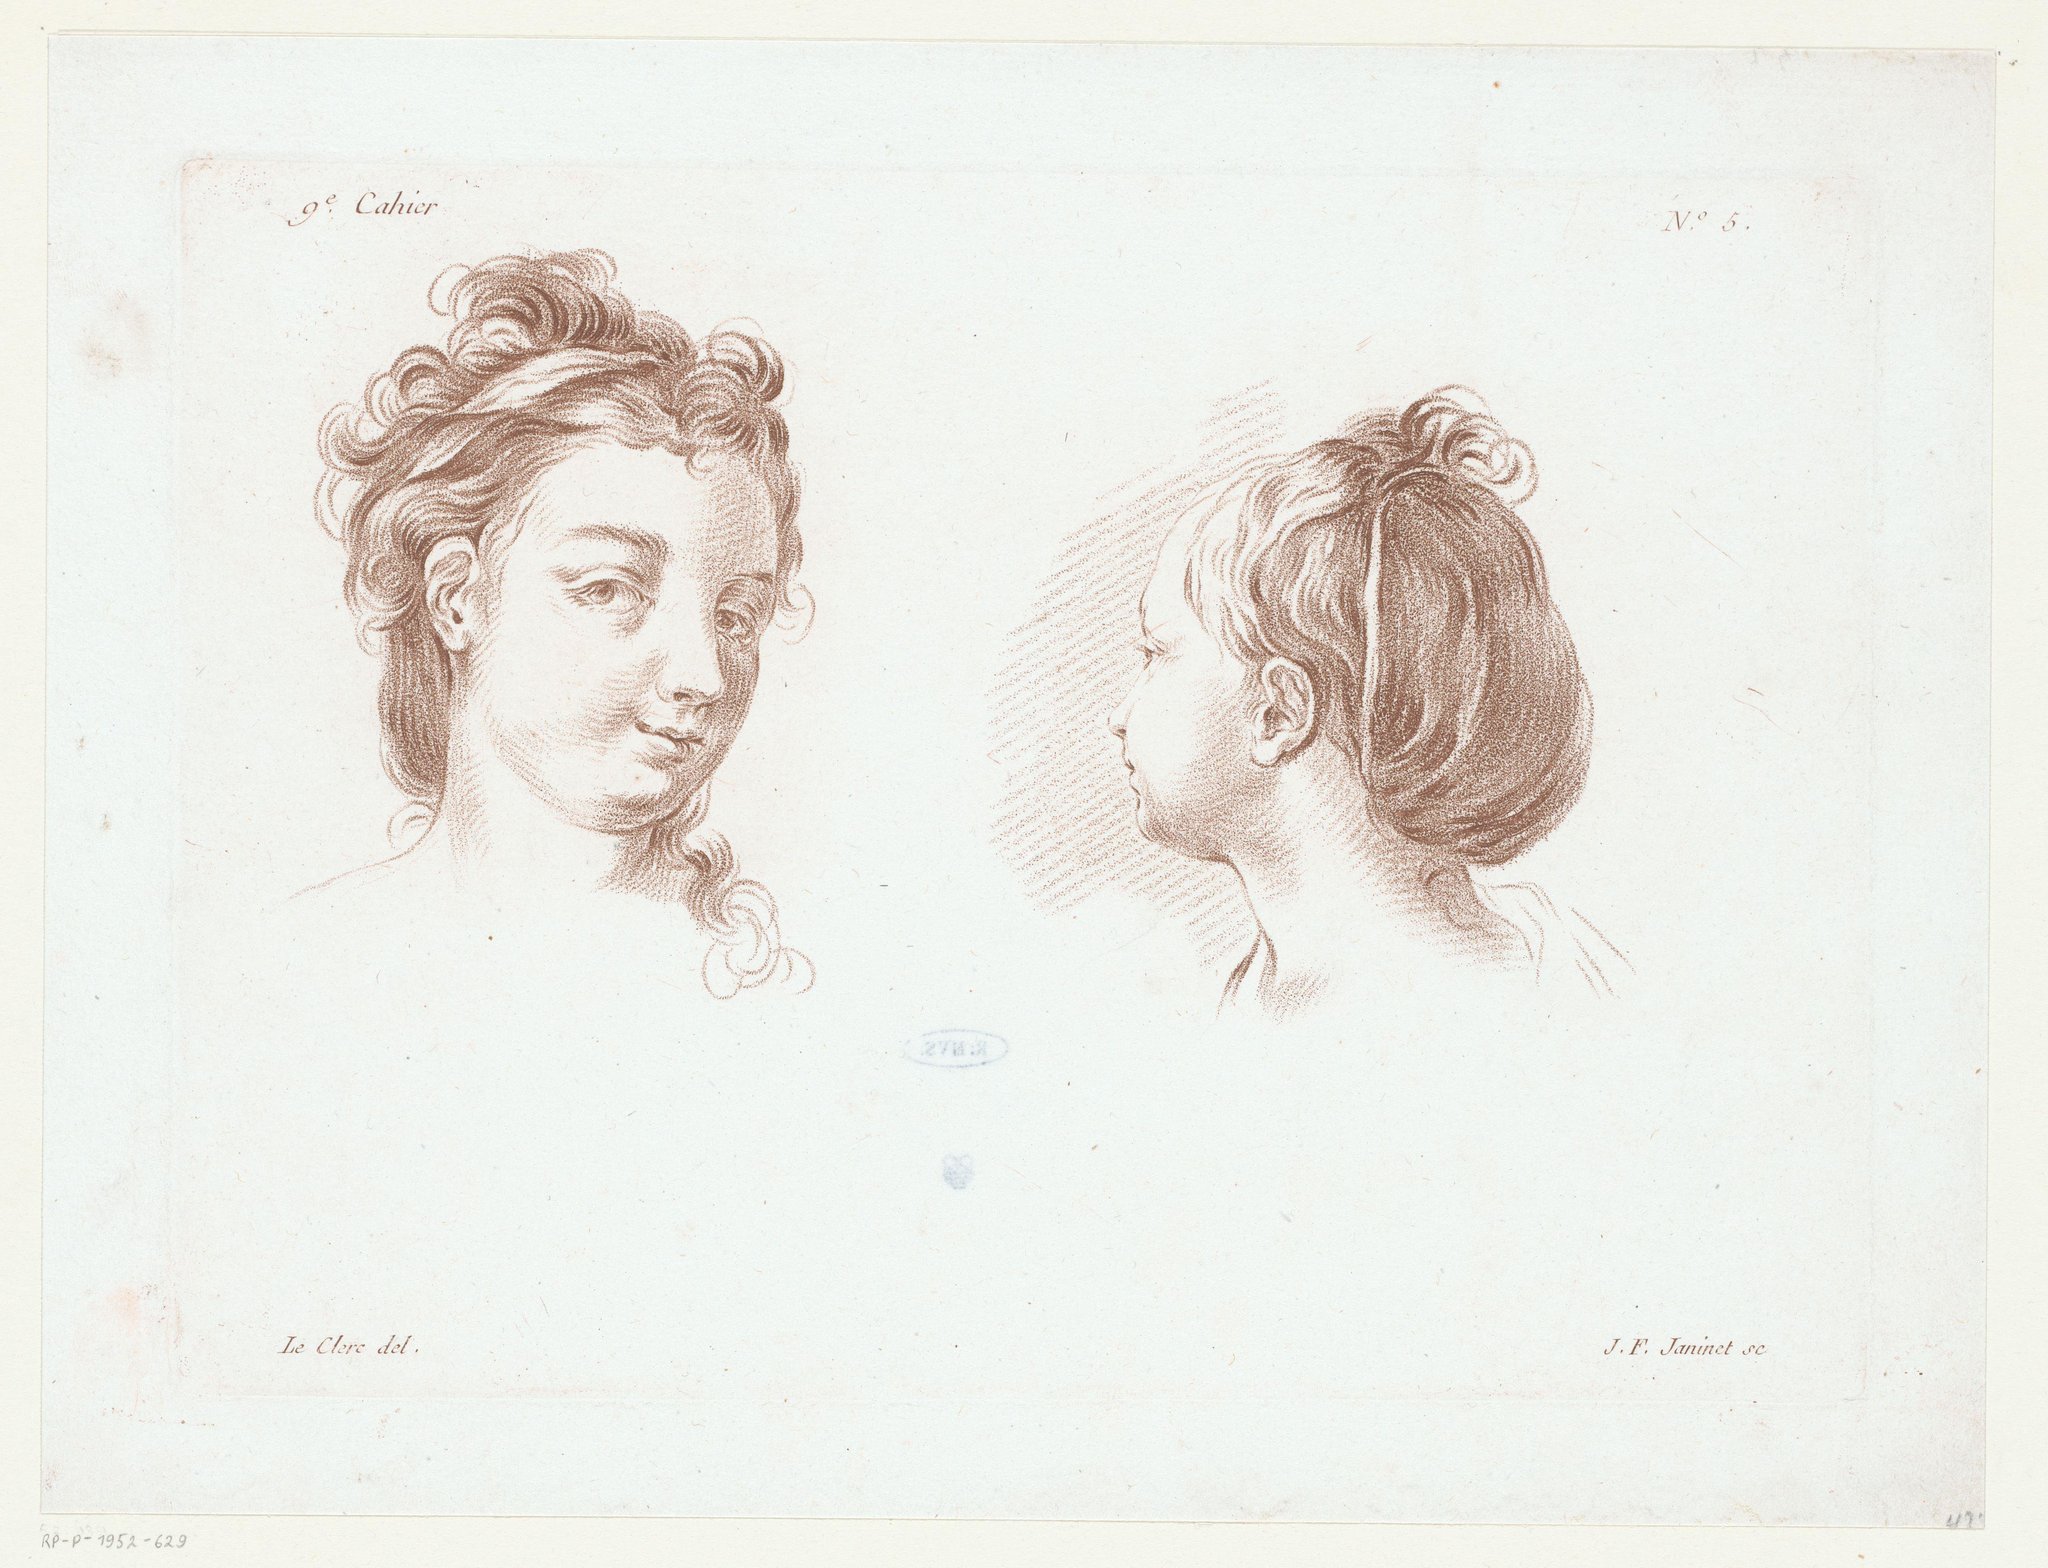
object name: print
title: Twee vrouwenhoofden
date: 1773-1777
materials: paper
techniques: printmaking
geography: paris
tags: head (human) - aa - female human figure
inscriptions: collector's mark: Lugt 2760, collector's mark: Lugt 2228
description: Deze prent maakt deel uit van een album dat uit minstens elf delen bestaat. Dit is het vijfde blad uit het negende album. Waarschijnlijk dienden deze albums als voorbeeld voor tekenaars, schilders en graveurs.